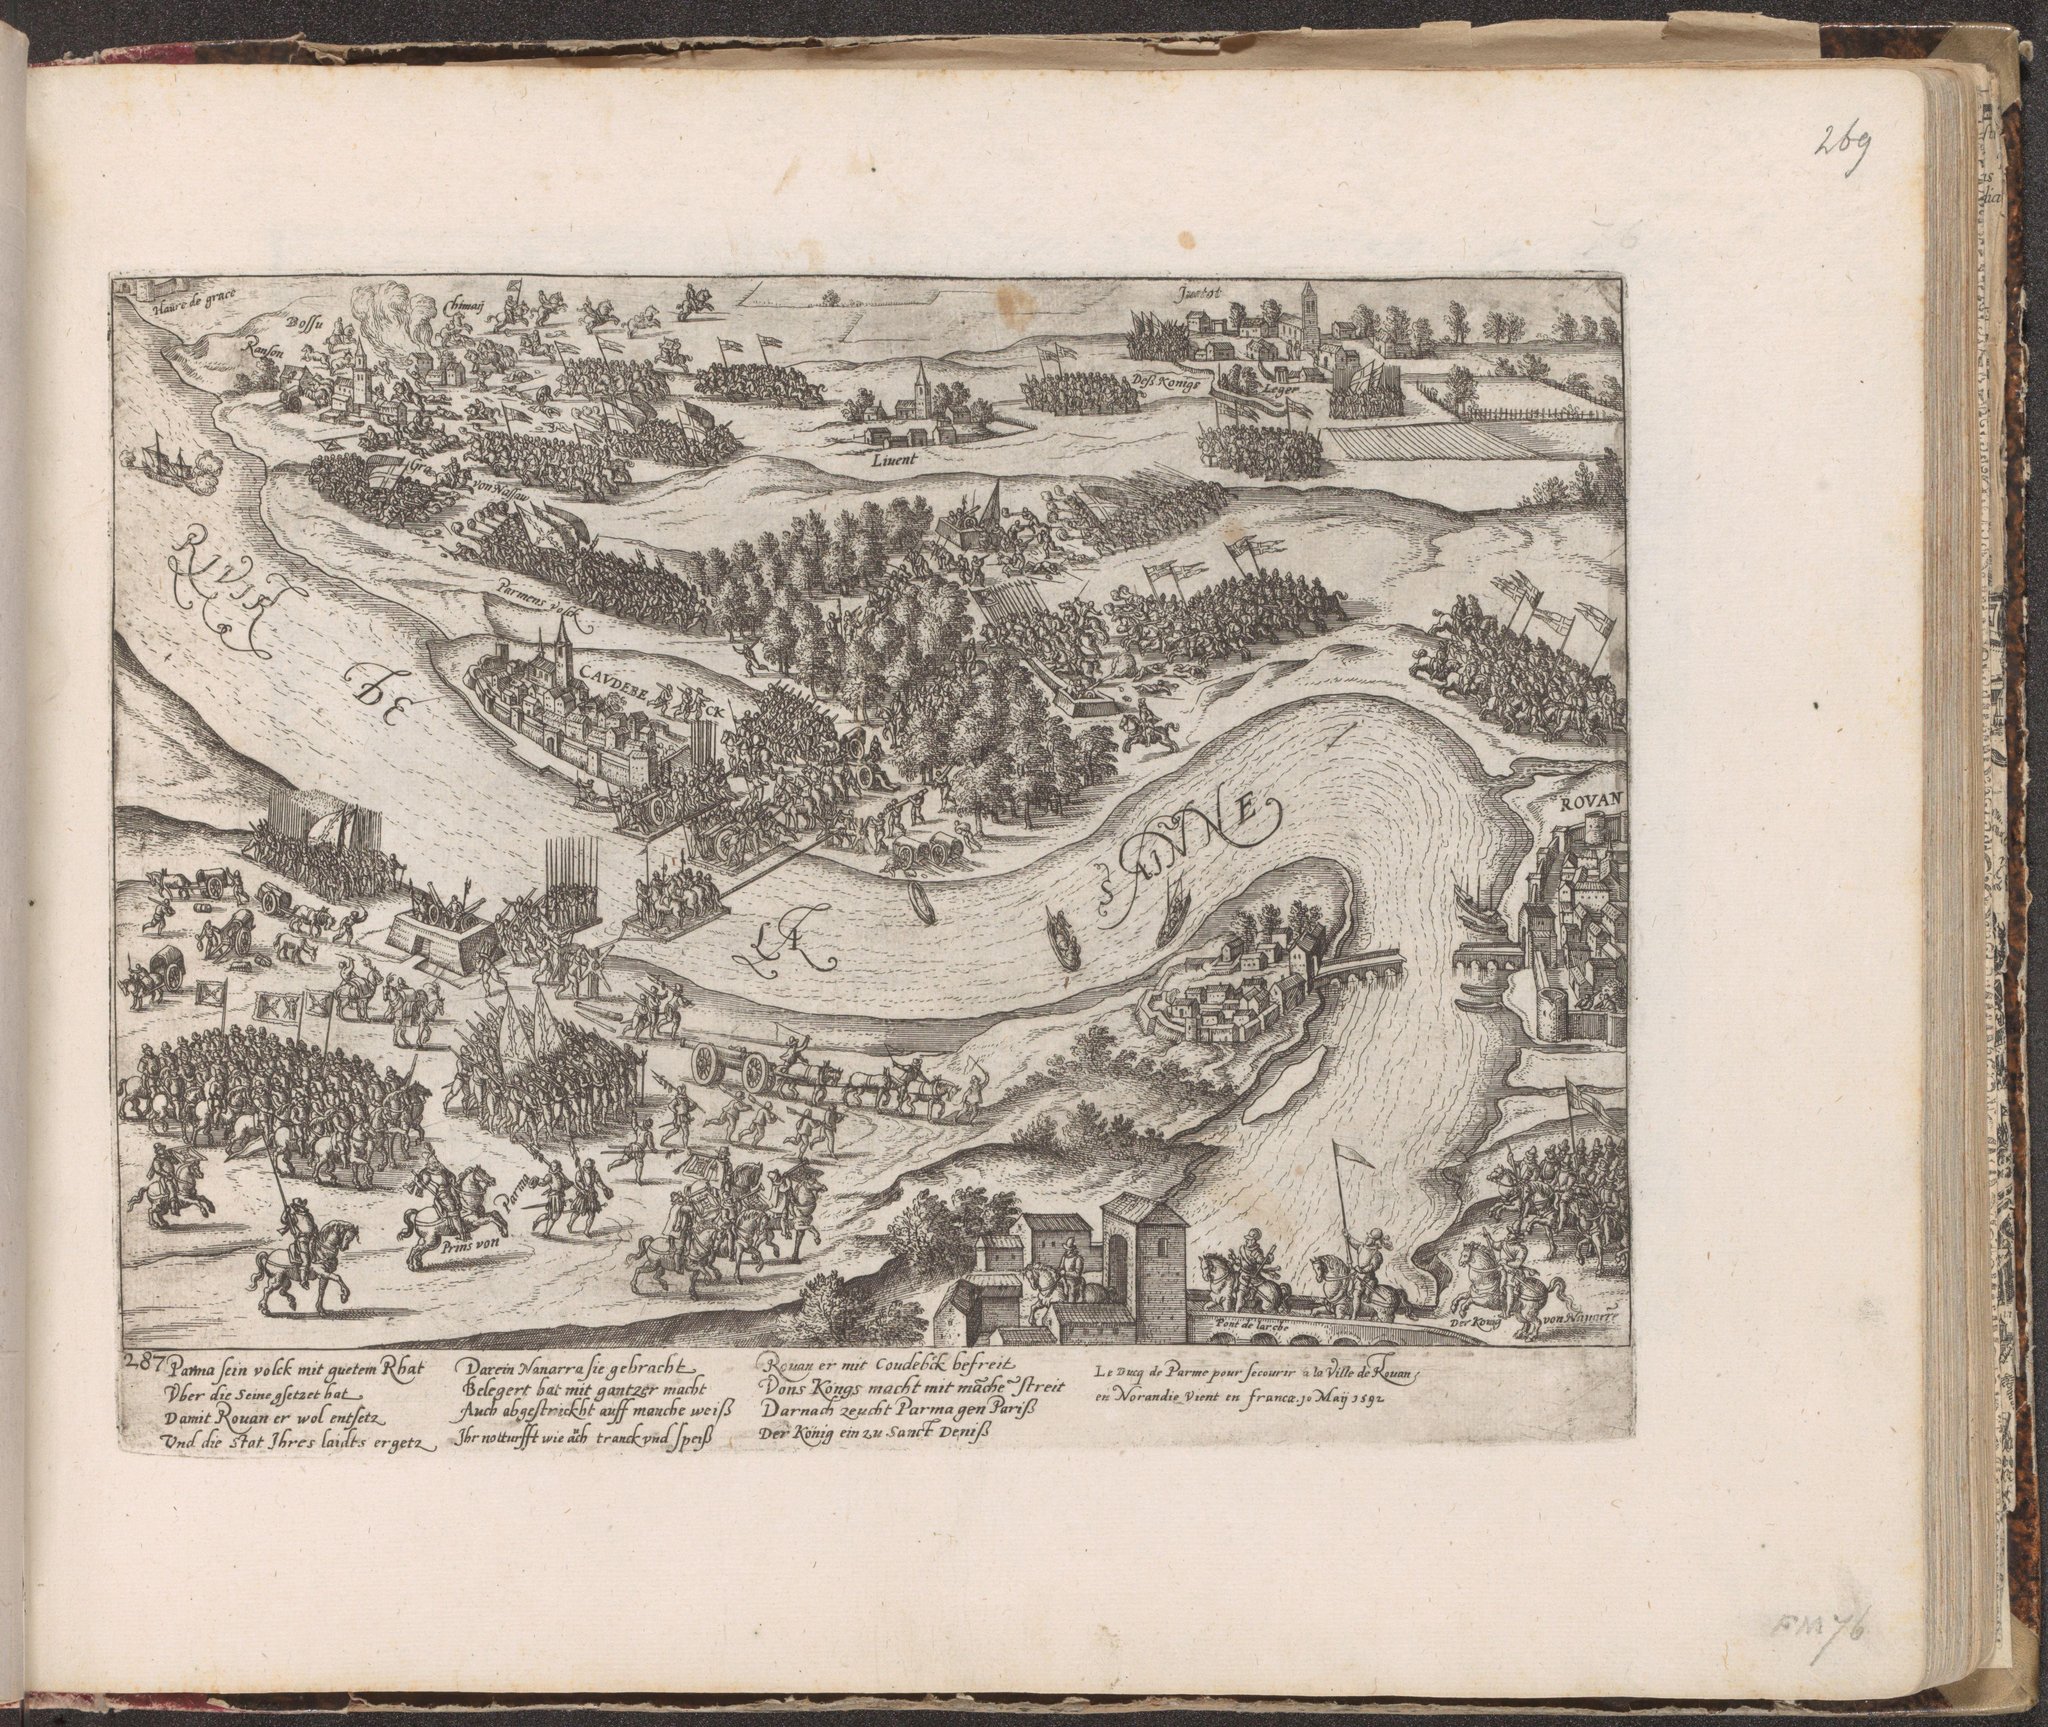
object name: album leaf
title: Parma steekt bij Caudebec de Seine over, 1592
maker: frans hogenberg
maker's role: print maker, publisher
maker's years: 1538-1590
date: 1592-1594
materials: paper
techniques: etching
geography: cologne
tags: rome, alessandro farnese (landvoogd van de nederlanden en hertog van parma en piacenza), paris, hendrik iv (koning van frankrijk en navarra), raising the siege with outside assistance, relief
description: Het leger van de hertog van Parma steekt op vlotten bij Caudebec de Seine over, 10 mei 1592. Rechtsonder Rouen en koning Hendrik IV. Met onderschrift van 12 regels in het Duits en 2 regels in het Frans. Linksonder genummerd: 287. De prent maakt deel uit van een album.